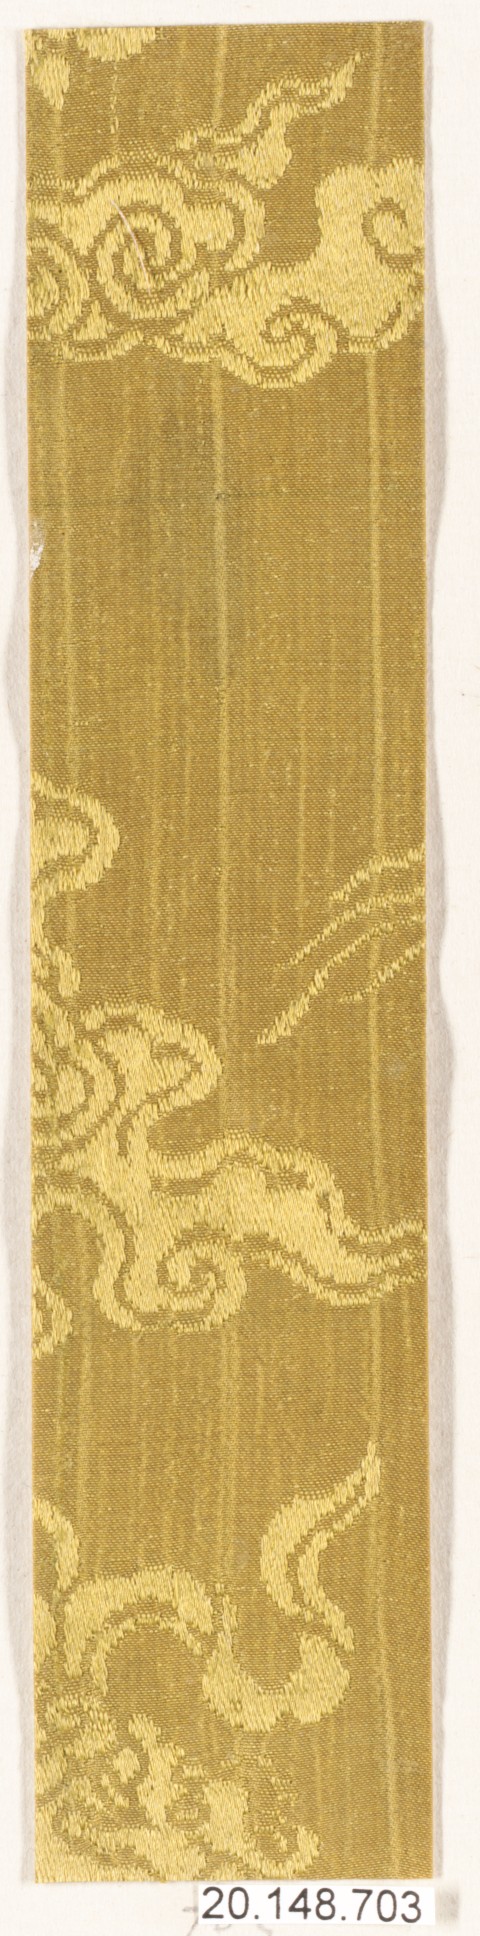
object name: piece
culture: japanese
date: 1701-1800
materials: silk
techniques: compound weave